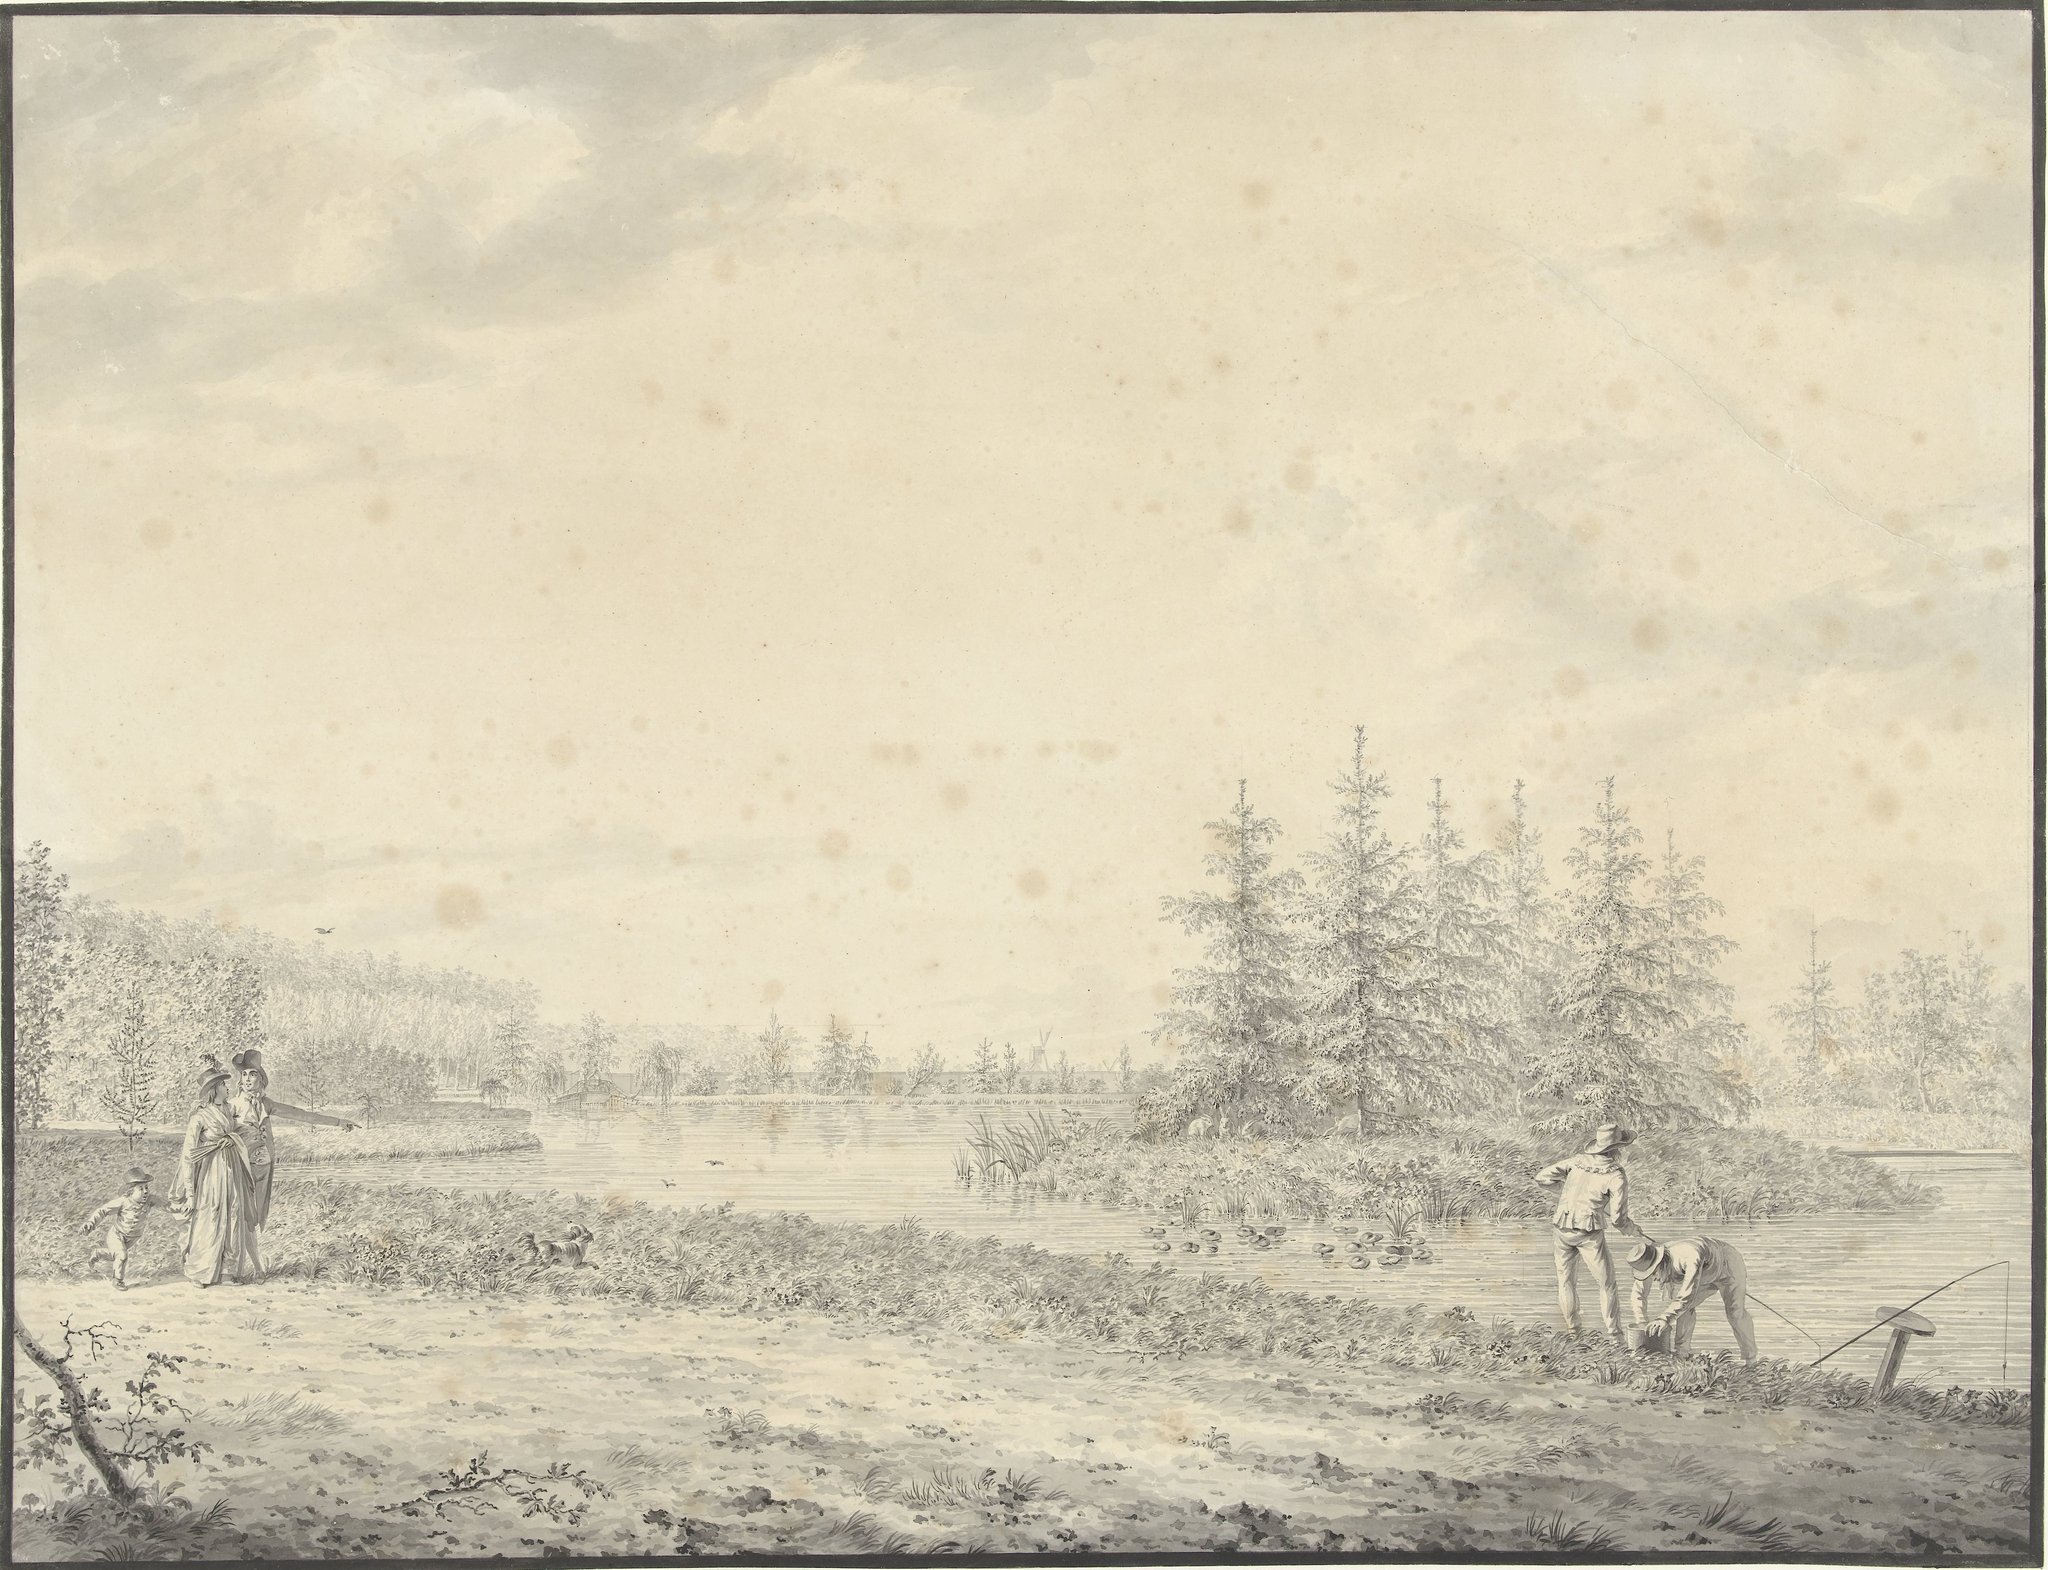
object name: drawing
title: Parklandschap met wandelaars en hengelaars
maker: Anonymous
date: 1700-1800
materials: ink, paper, pencil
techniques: brush, pen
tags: public gardens, park